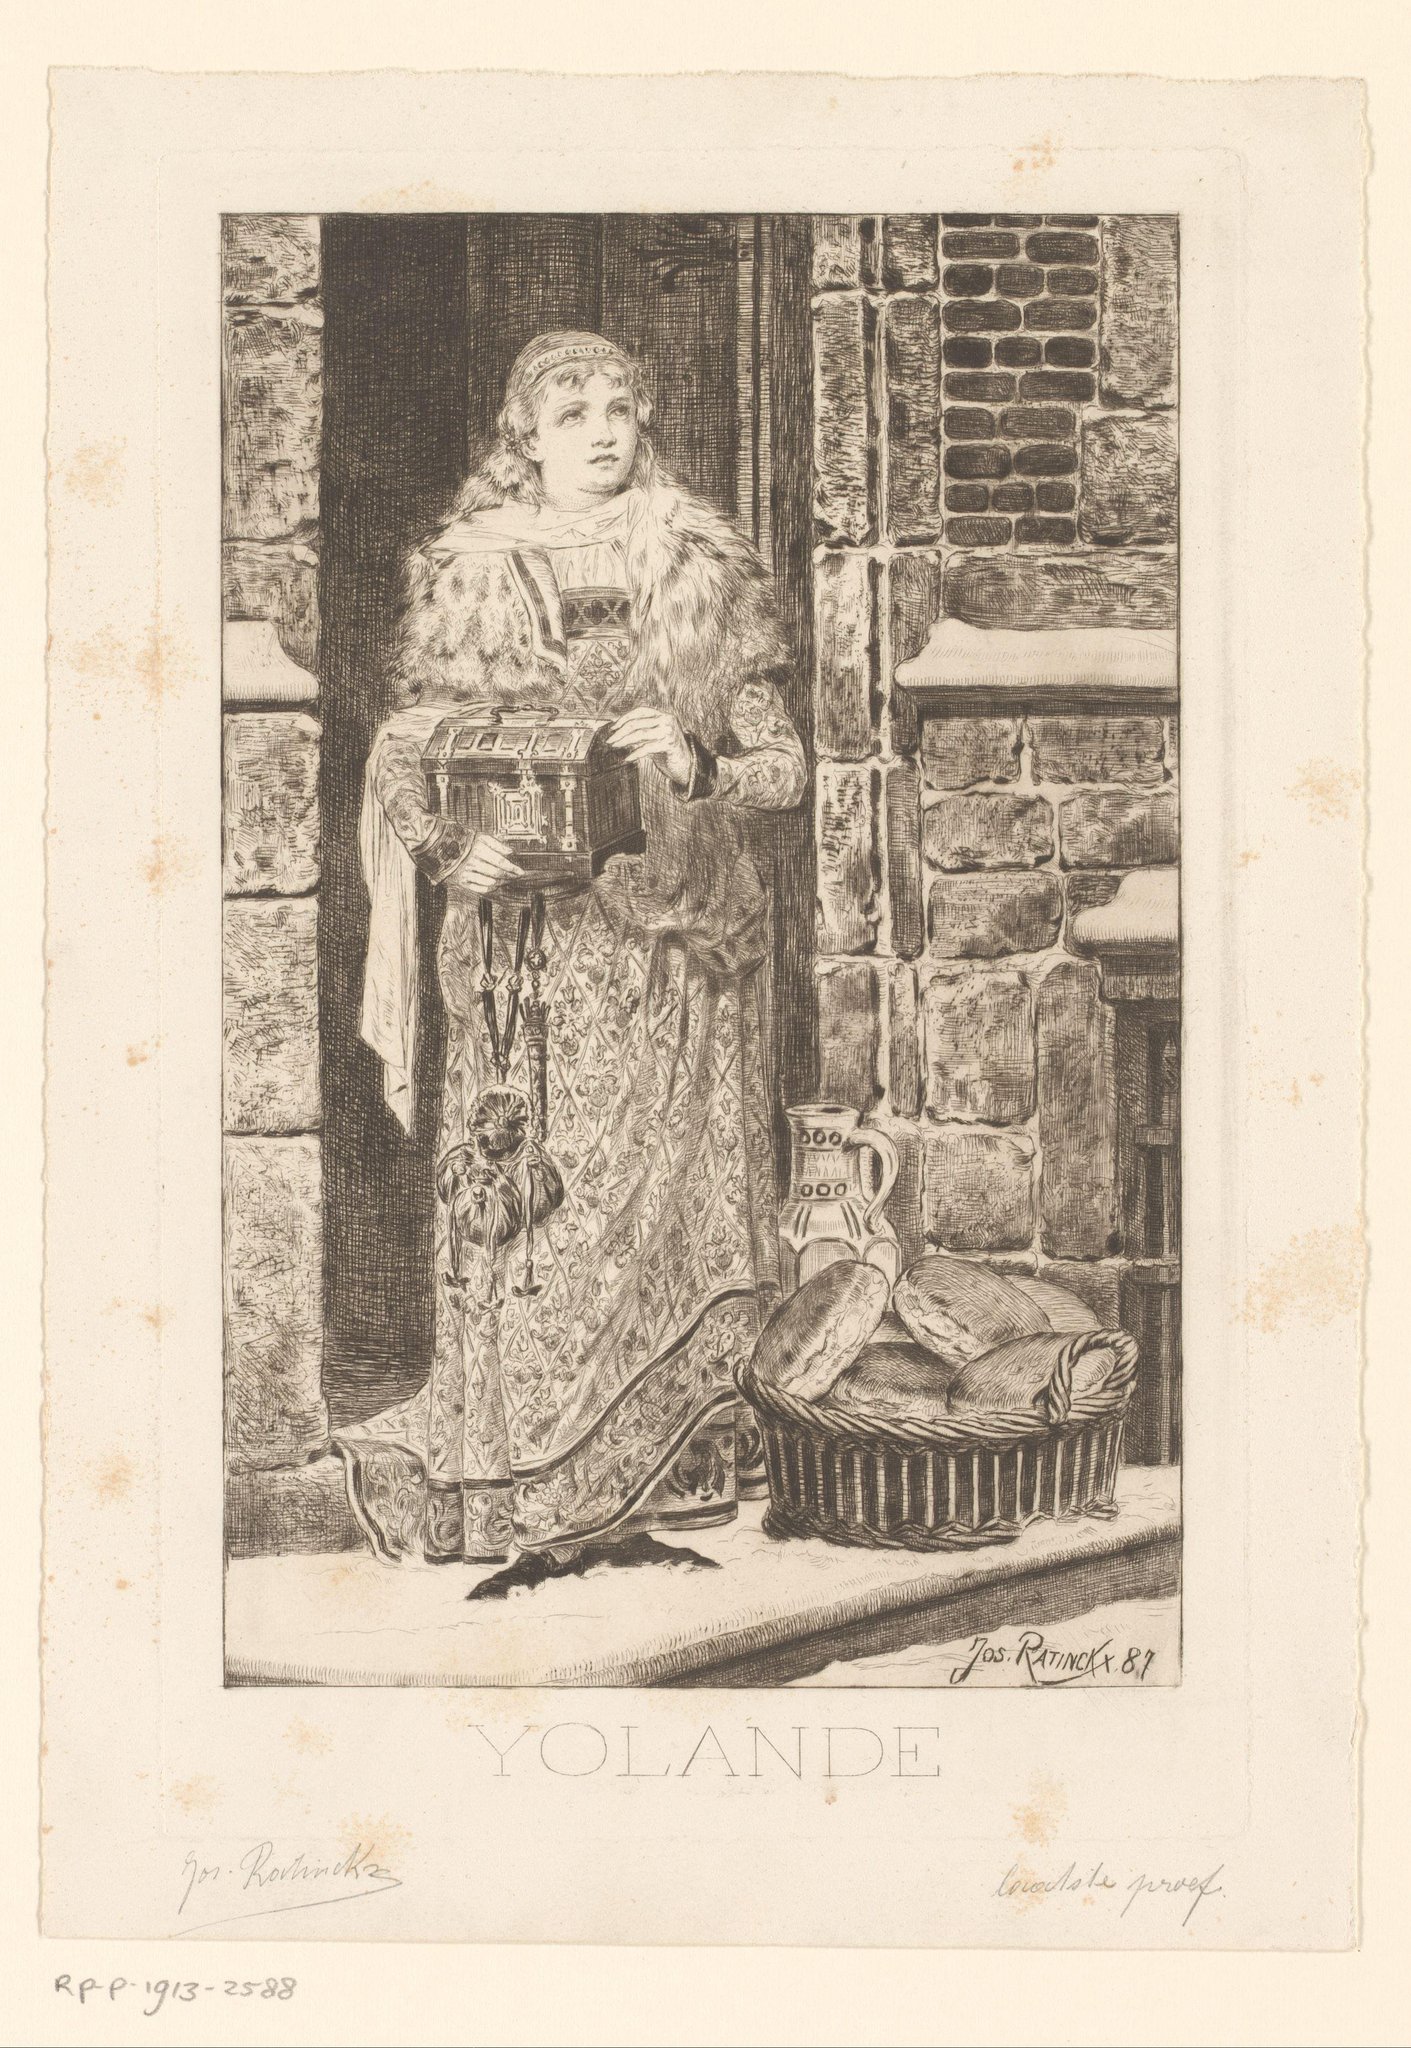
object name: print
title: Jonge vrouw met kostbaarheden en brood staand voor een huis in de sneeuw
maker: jos ratinckx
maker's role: print maker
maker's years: 1860-1937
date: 1887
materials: paper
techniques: drypoint, etching, roulette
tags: adolescent, young woman, maiden, bread, loaf, snow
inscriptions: collector's mark: Lugt 2228, inscription: ‘laatste proef’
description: Mogelijk gaat het om een voorstelling uit het stuk 'Yolande' van Emile Wambach.